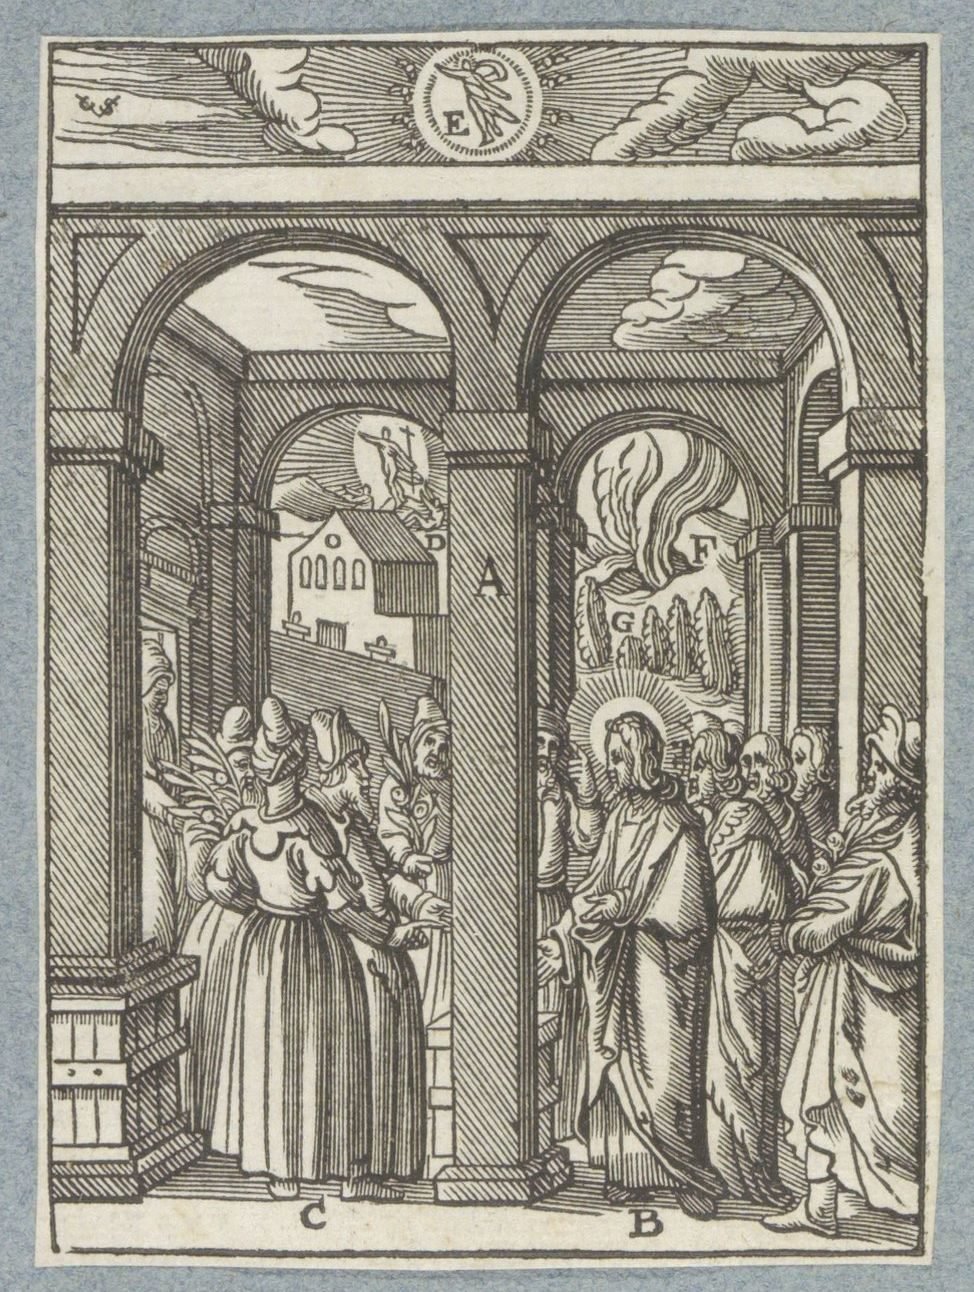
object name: print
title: Christus met de farizeeën in gesprek in de tempel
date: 1629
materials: paper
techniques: letterpress printing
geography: amsterdam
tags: pharisees and sadducees opposing christ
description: De prent is afkomstig uit een van de uitgaven van P.J. Paets uit Amsterdam. Ze wordt voor het eerst gebruikt in: Der Zielen Lust-hof. Leuven, I.Jacbosz voor P.J. Paets [= Amsterdam, P.J. Paets], 1629. De voorstelling is gekopieerd naar een prent van Antonie II Wierix voor: Nadal, Jerónimo. Evangelicae Historiae Imagines. Antwerpen, M. Nutius, 1593.